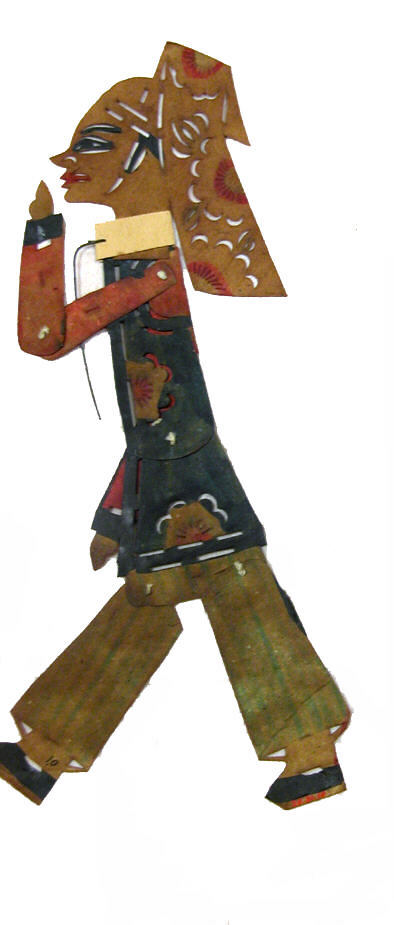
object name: shadow player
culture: chinese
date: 1801-1900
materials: cord, skin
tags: women